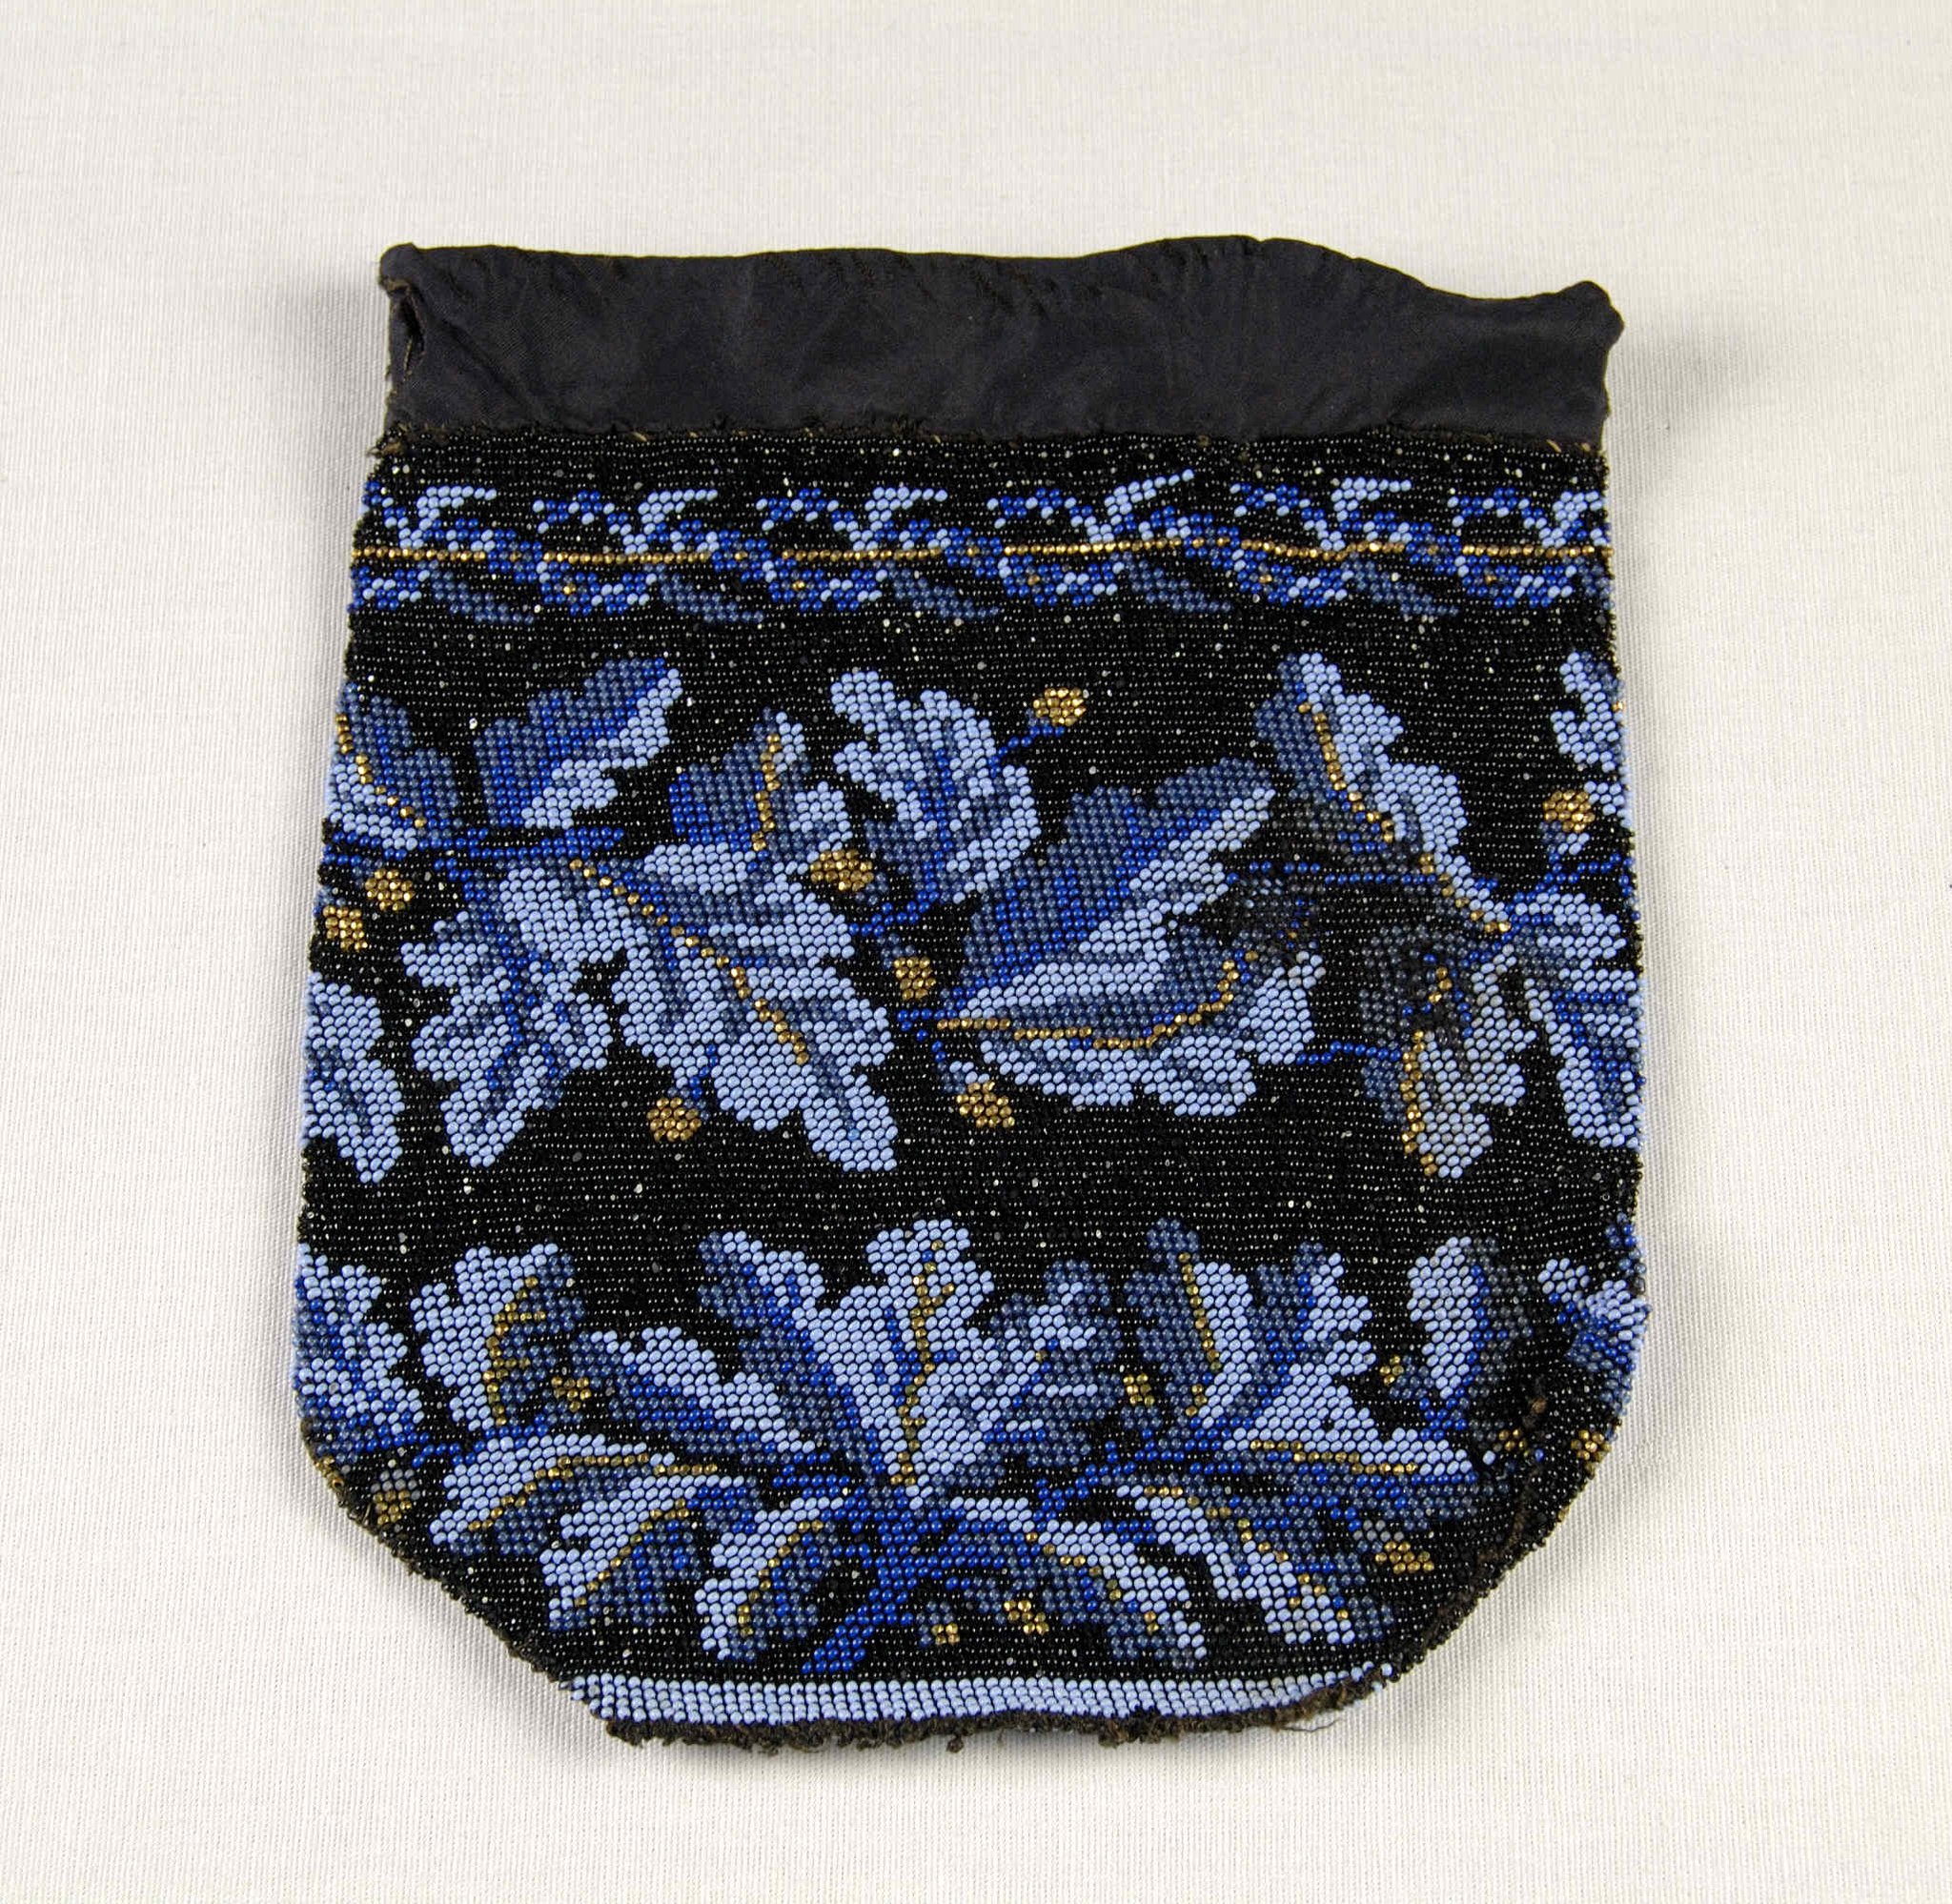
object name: pouch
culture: american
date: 1876-1900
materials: glass, leather, linen, silk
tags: leaves